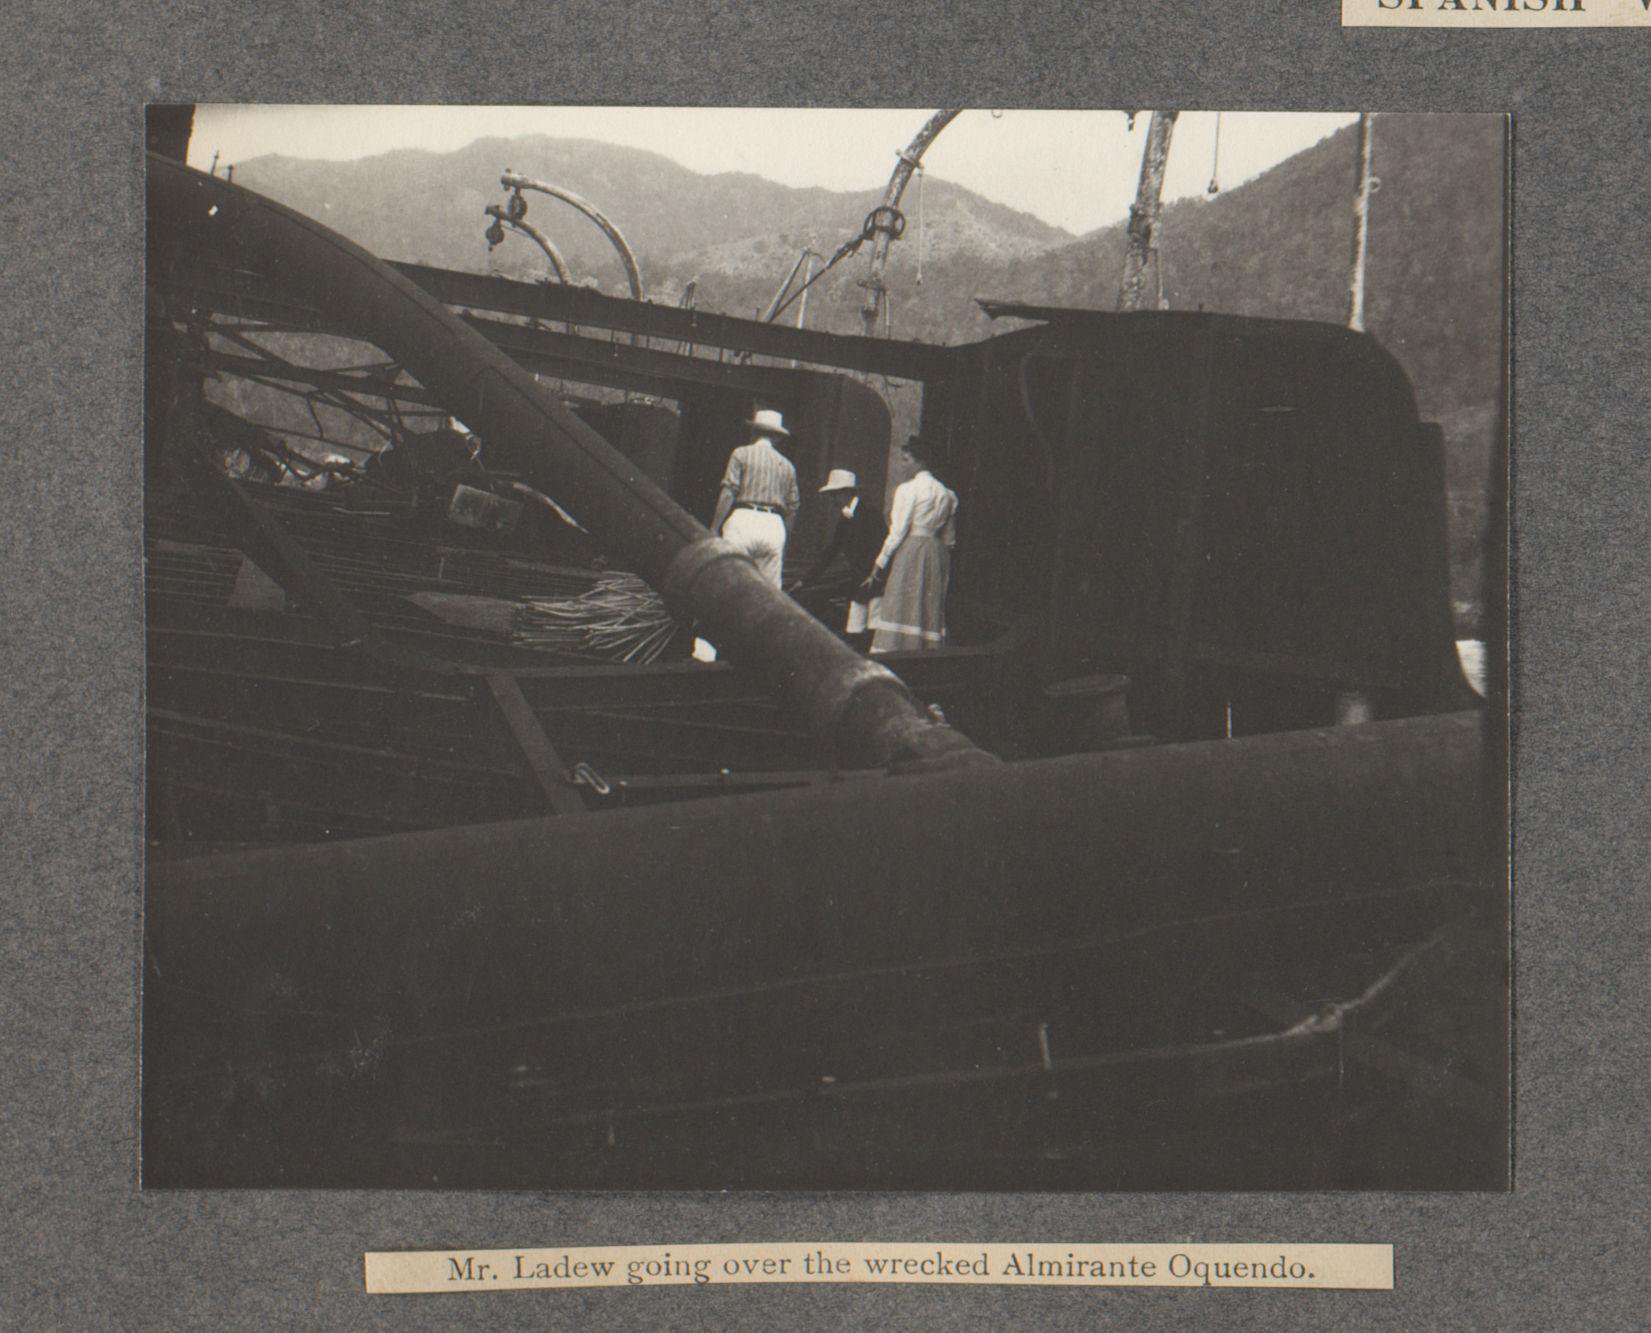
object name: album leaf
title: Joseph Harvey Ladew en zijn reisgezelschap op het wrak van de Almirante Oquendo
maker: Anonymous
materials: paper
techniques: platinum process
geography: santiago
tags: joseph harvey ladew sr., gulf, bay, historical persons, shipwreck